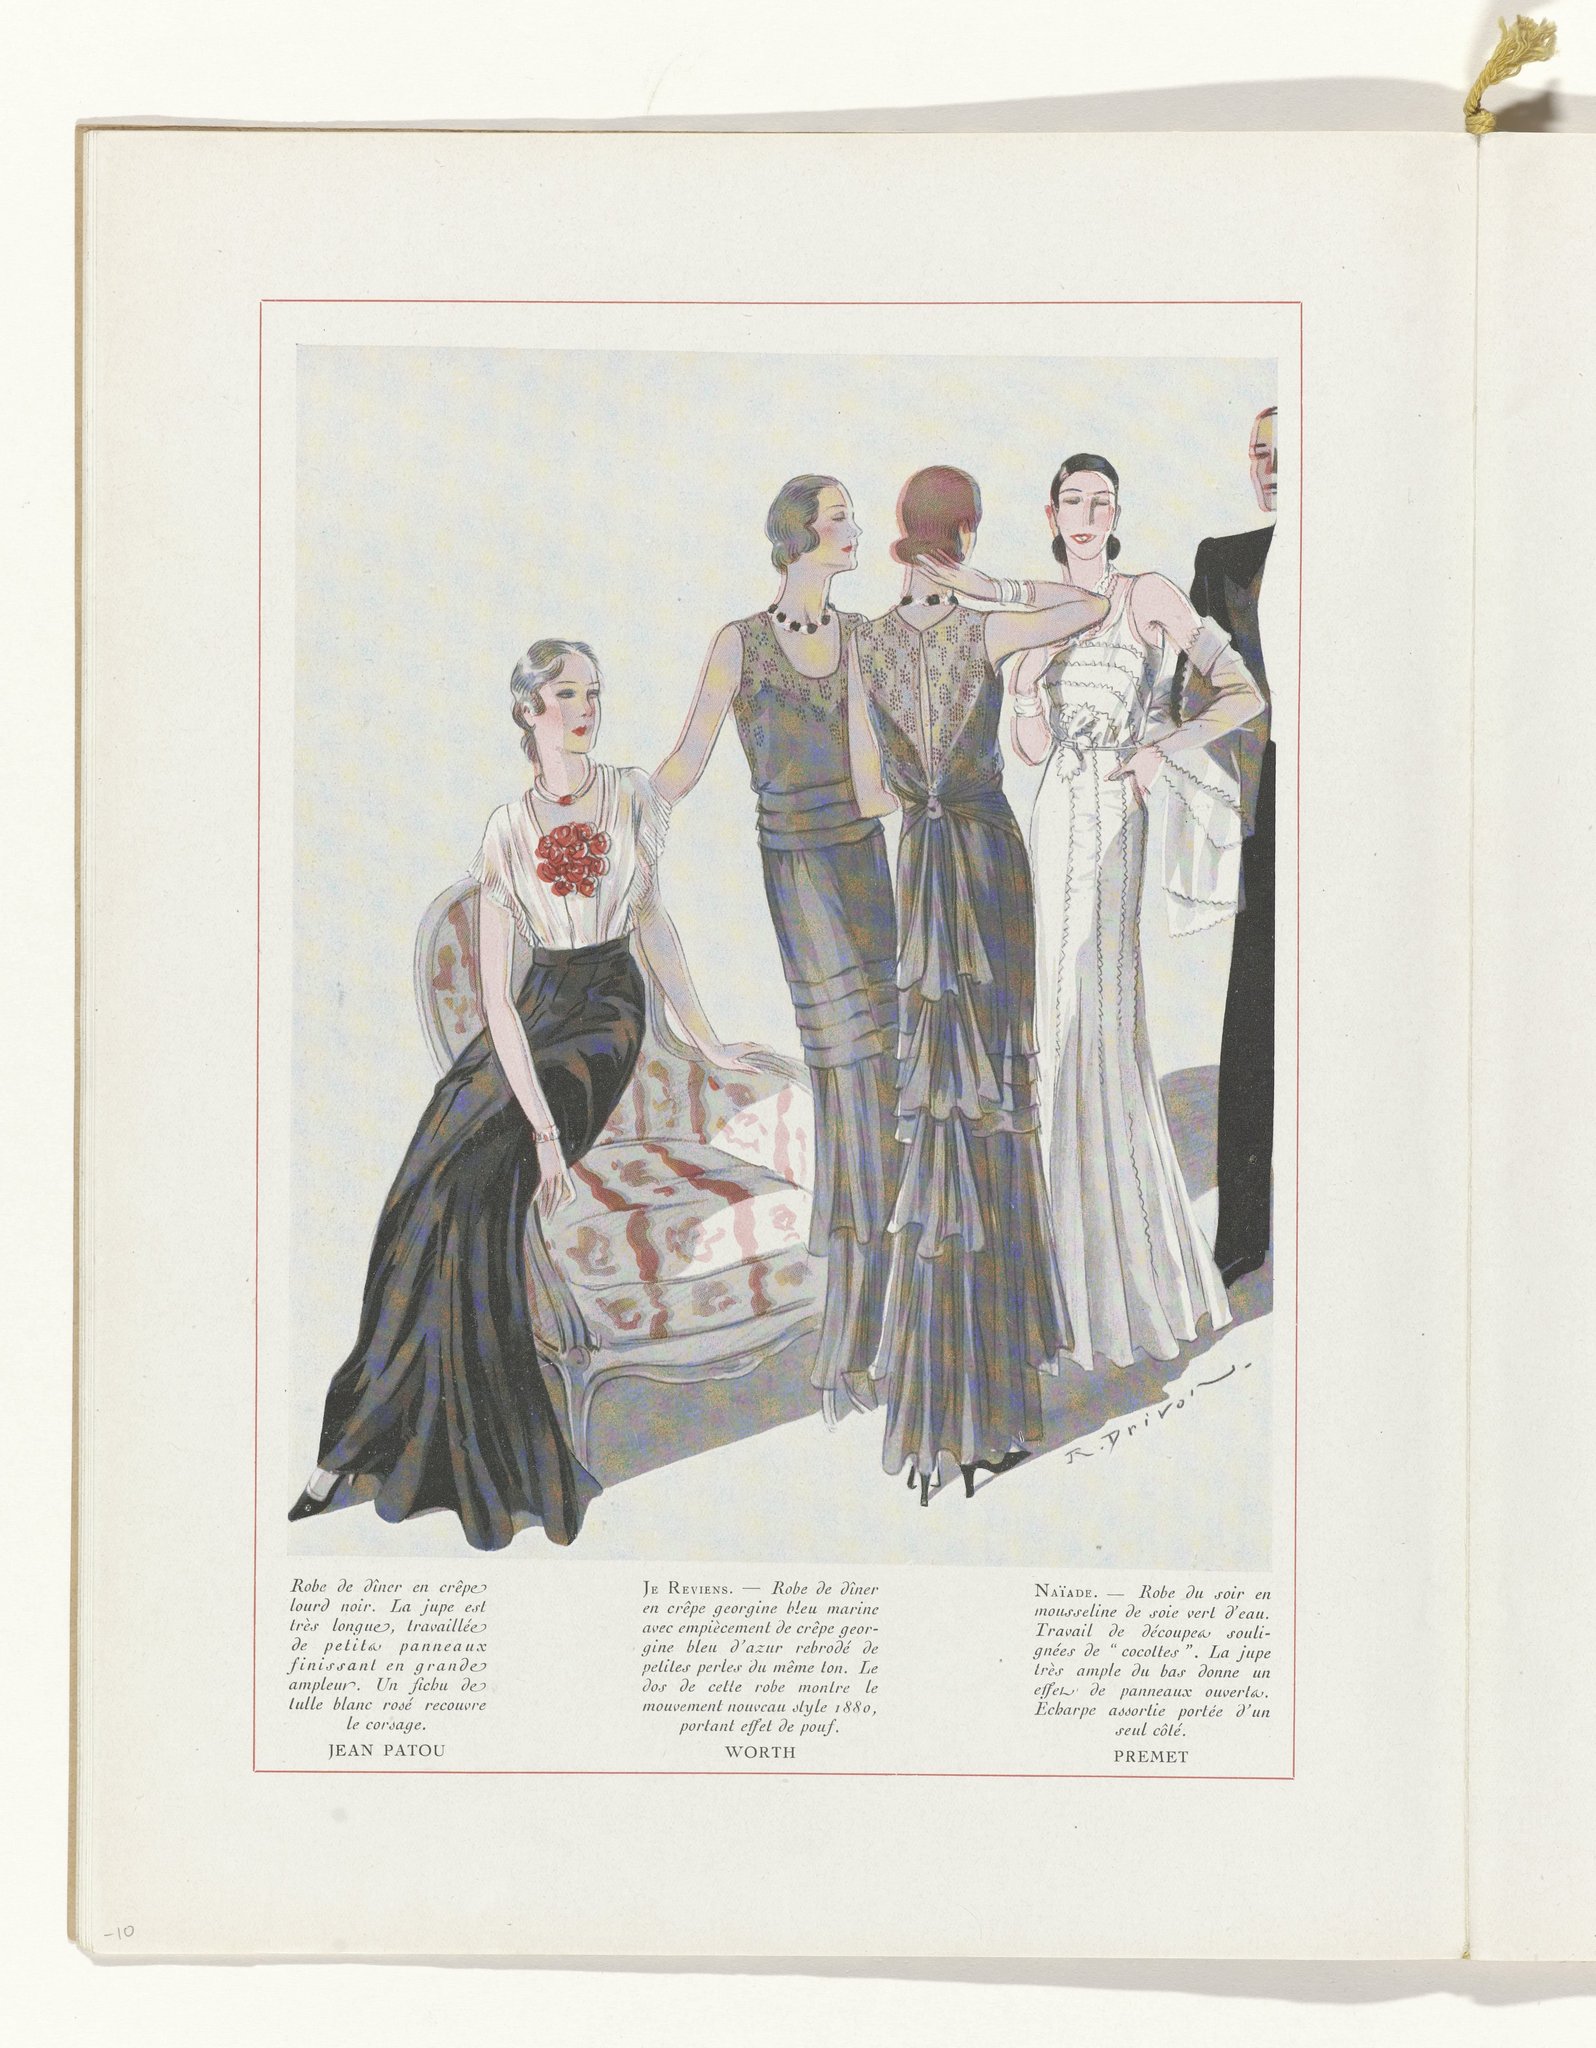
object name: magazine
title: Art - Goût - Beauté, Feuillets de l' élégance féminine, Novembre 1931, No. 135, 12e Année, p. 10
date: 1931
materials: paper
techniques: printing, photography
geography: paris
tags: corsage (+ women's clothes), flowers, dress, gown: evening dress (+ women's clothes), clothing for the upper part of the body (shawl) (+ women's clothes), dress, gown: dinner dress (+ women's clothes), fashion plates, piece of clothing covering the breast or décolleté (fichu) (+ women's clothes)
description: Links: dinerjapon van zwarte crêpe en een fichu van roze/witte tule met bloemcorsage, van Jean Patou. Midden: dinerjapon van marineblauwe 'crêpe georgine', van Worth. Rechts: avondjurk van zijdemousseline, van Premet. Pagina uit het modetijdschrift Art-Goût-Beauté (1920-1933).